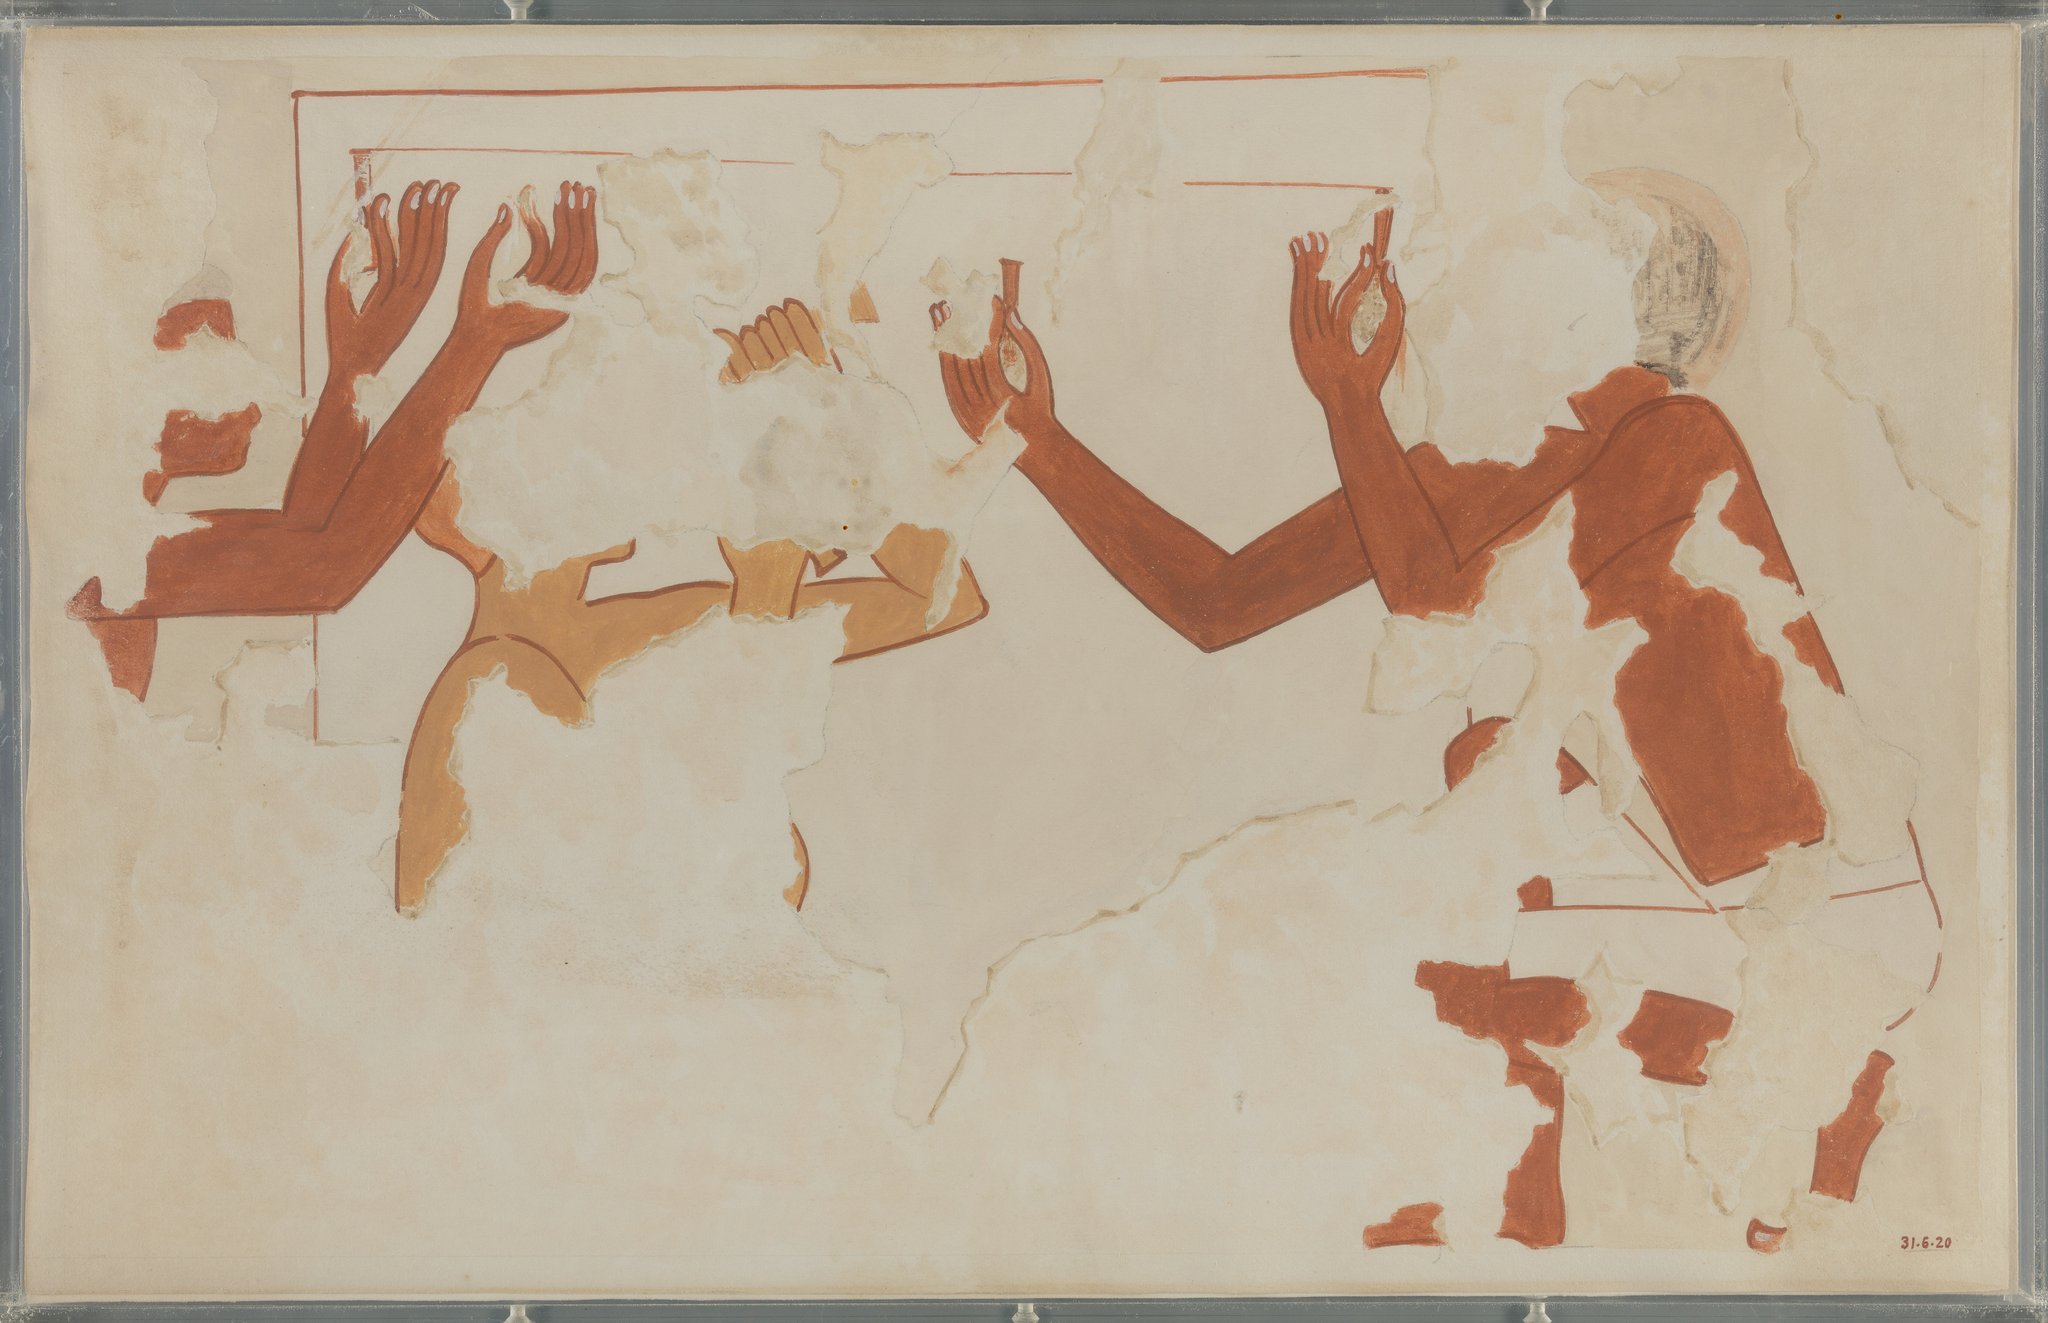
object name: facsimile, rekhmire tt 100, stone cutting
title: Stone Cutters Measuring a Block, Tomb of Rekhmire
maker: nina de garis davies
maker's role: artist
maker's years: 1881-1965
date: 1504-1425 BCE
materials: ink, paint, paper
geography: egypt